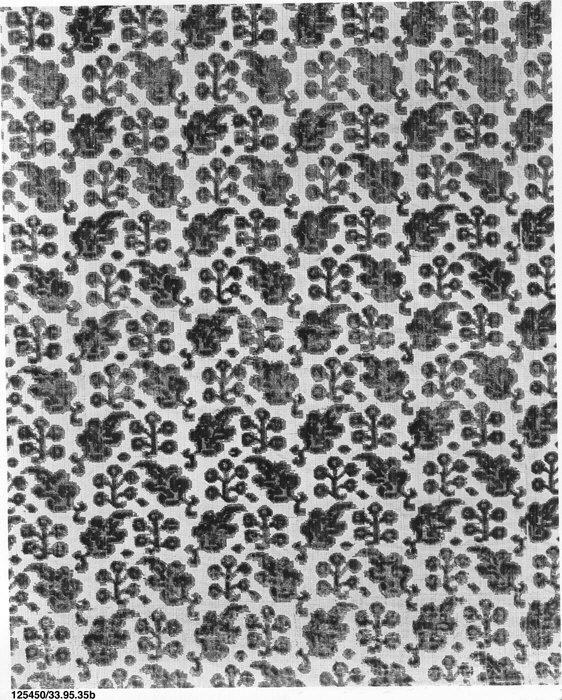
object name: piece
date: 1501-1700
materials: silk